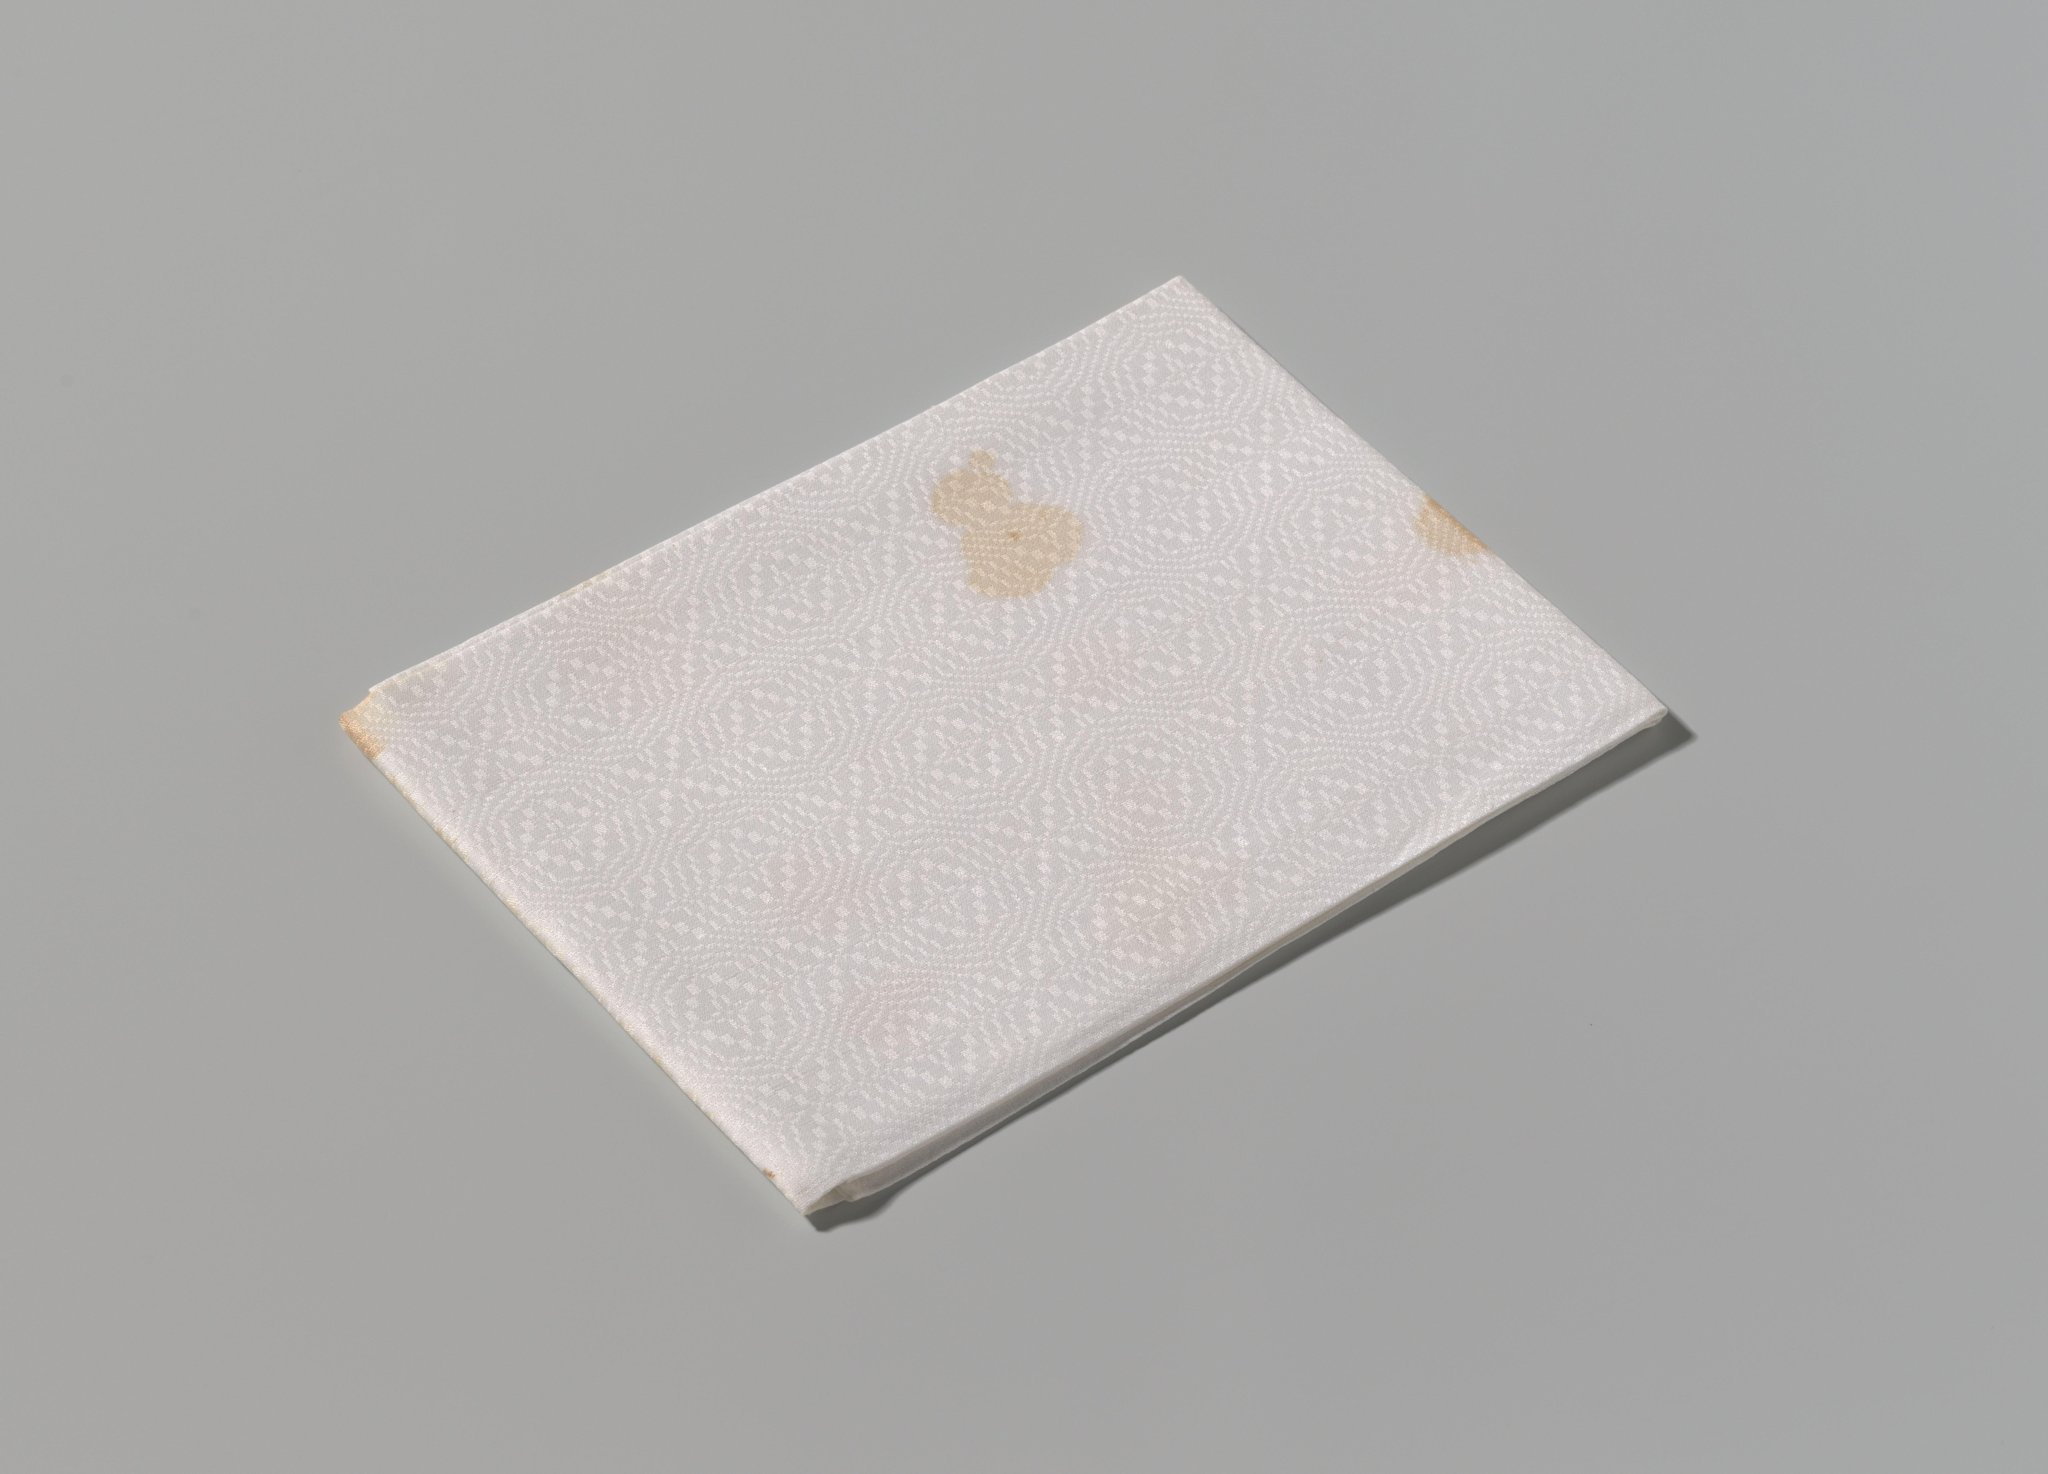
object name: napkin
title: Servet van pellendamast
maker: Anonymous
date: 1600-1699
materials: linen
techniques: weave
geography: netherlands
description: Servet van pellendamast. Het patroon heeft concentrische cirkelachtige vormen. Het servet is in rood gemerkt met een kruissteek: FVL 12. (Zie ook servet BK-1980-145).